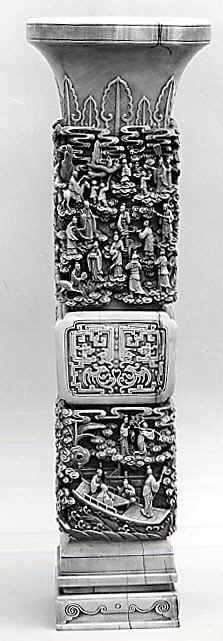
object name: vase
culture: chinese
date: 1662-1722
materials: ivory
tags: human figures,boats